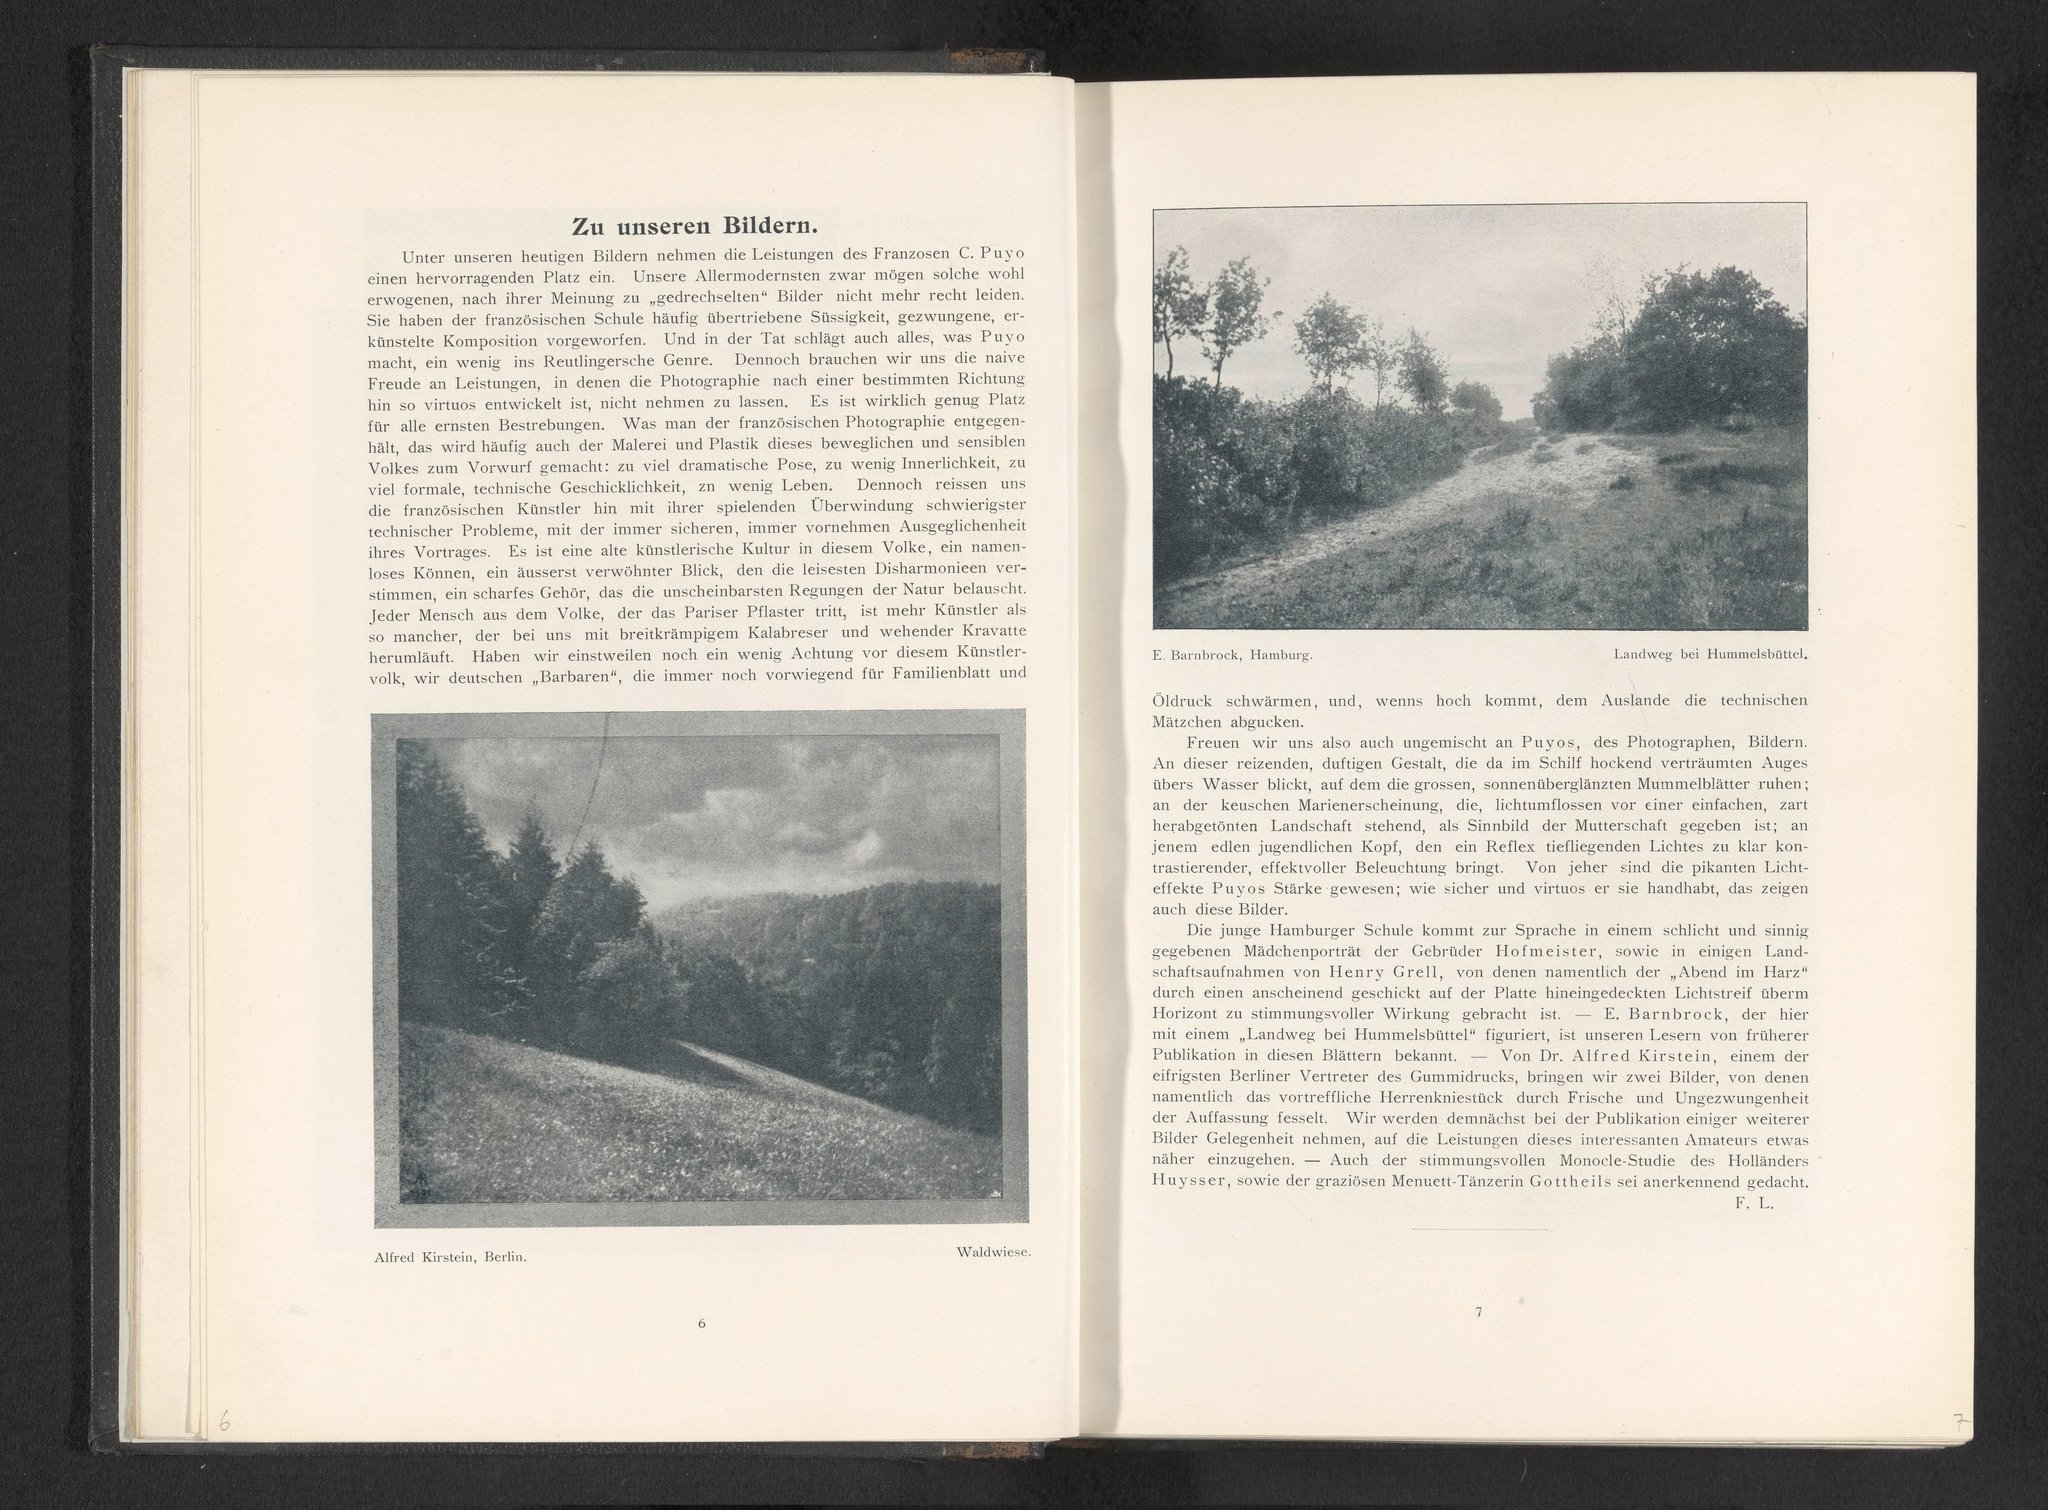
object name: page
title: Landschap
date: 1898-1903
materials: paper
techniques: autotype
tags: landscapes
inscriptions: monogram: ‘BX’